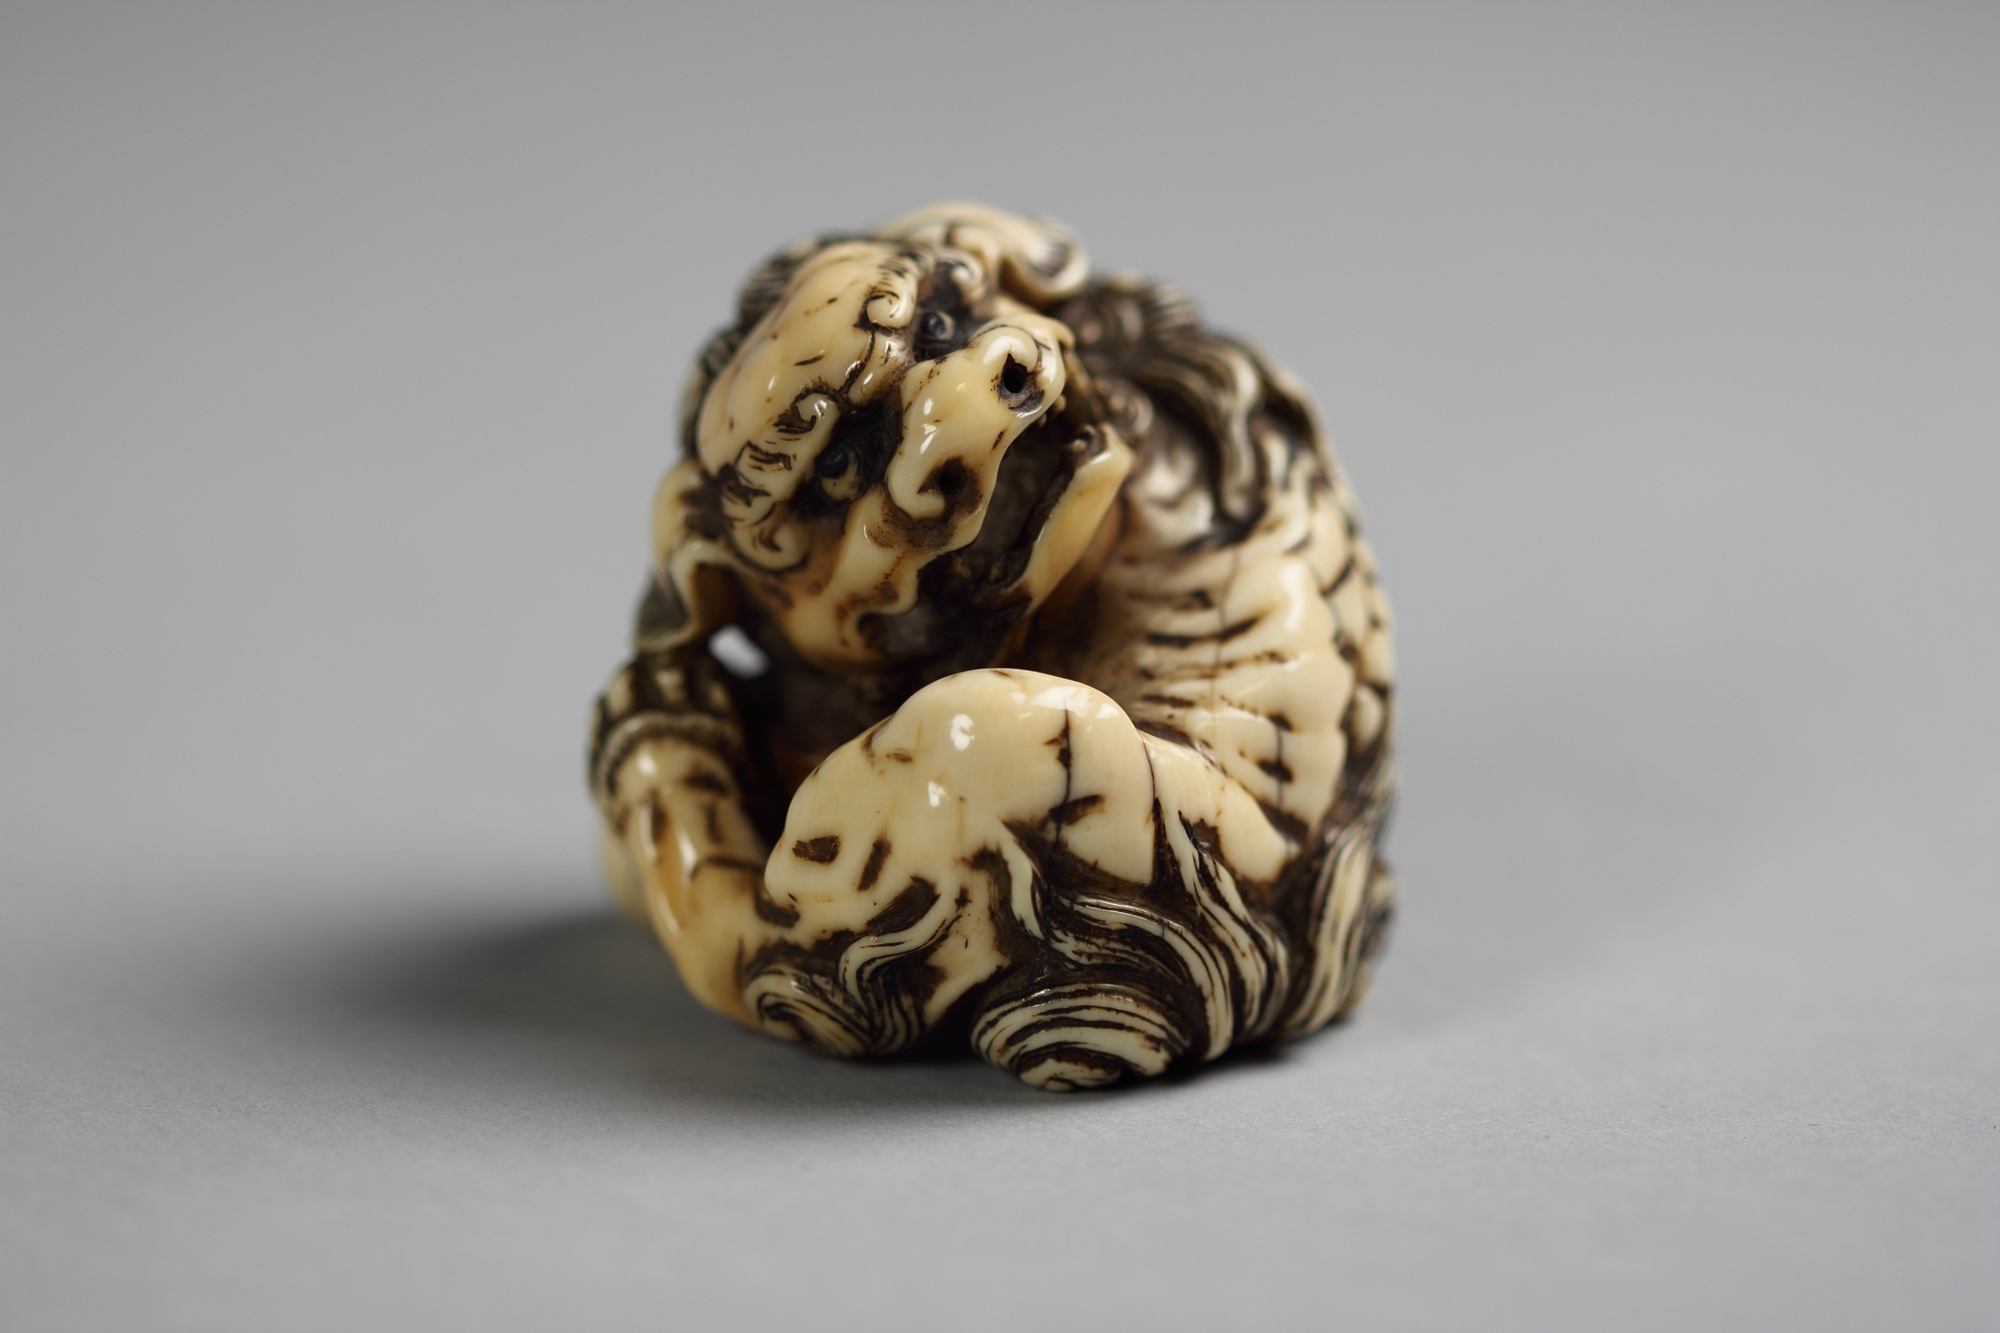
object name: netsuke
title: Netsuke of a Karashishi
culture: japanese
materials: ivory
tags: animals